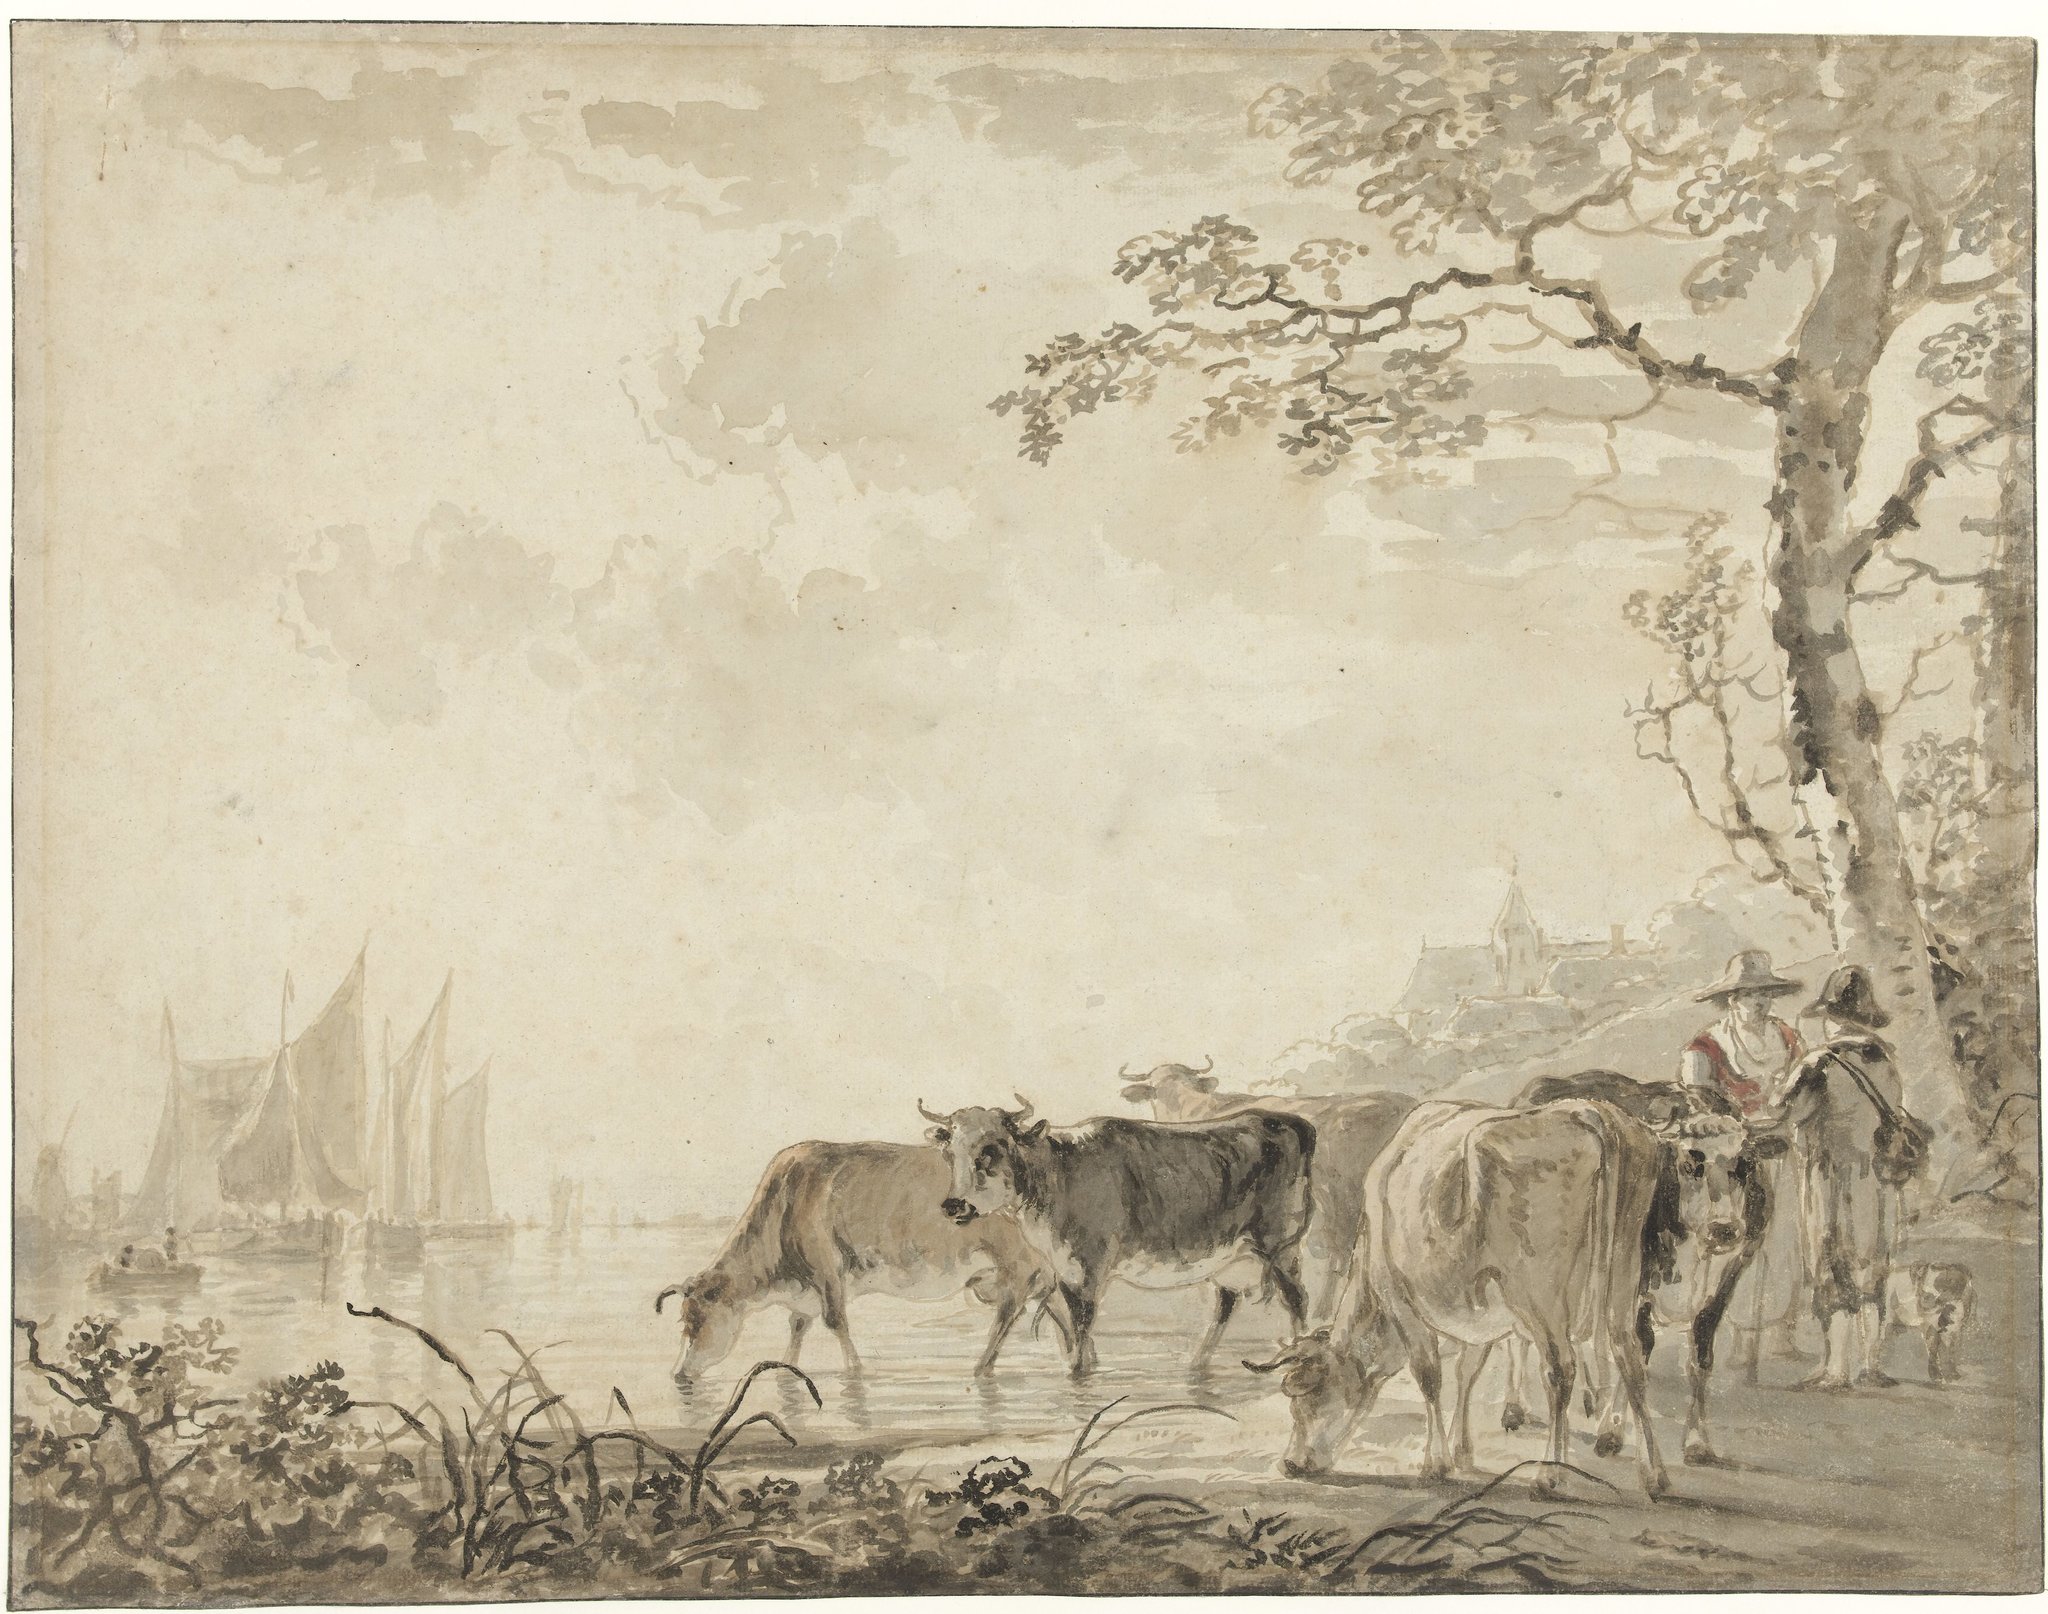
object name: drawing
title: Landschap met koeien bij een rivier met schepen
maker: jacob van strij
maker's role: draughtsman, painter, print maker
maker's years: 1756-1815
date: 1766-1815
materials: paper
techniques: brush